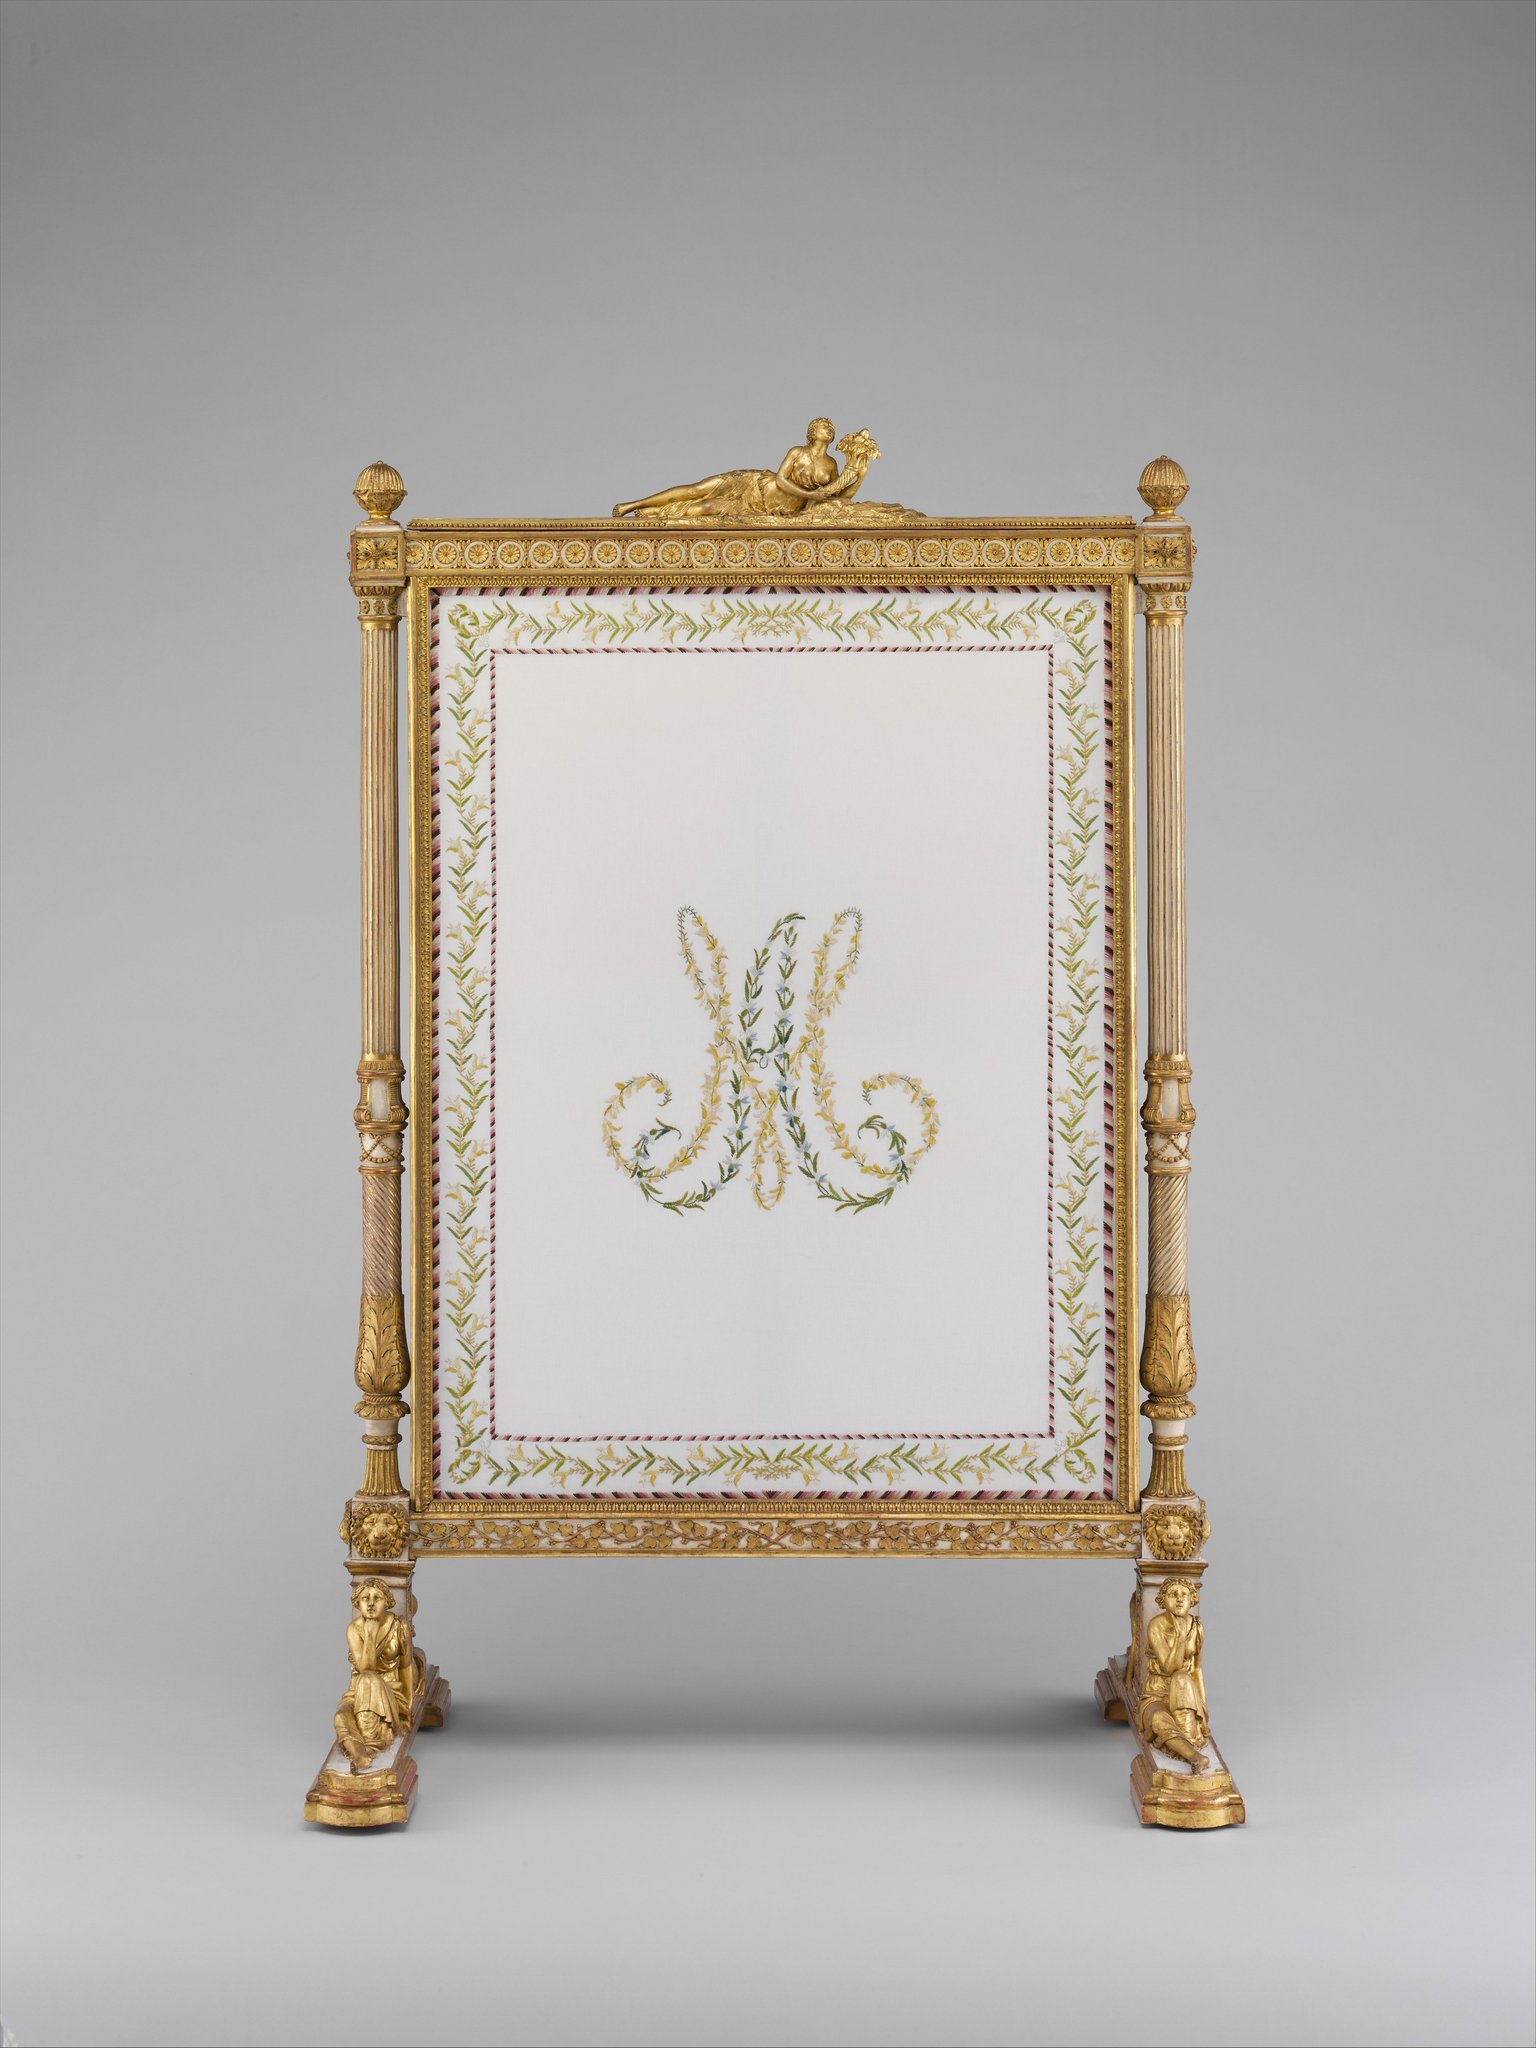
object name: fire screen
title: Fire screen (Écran) (part of a set)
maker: jean-baptiste-claude sené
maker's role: maker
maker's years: 1748-1803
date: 1788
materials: cotton, silk, wood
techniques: carving, embroidery, gilding, painting, weave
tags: women,insignia